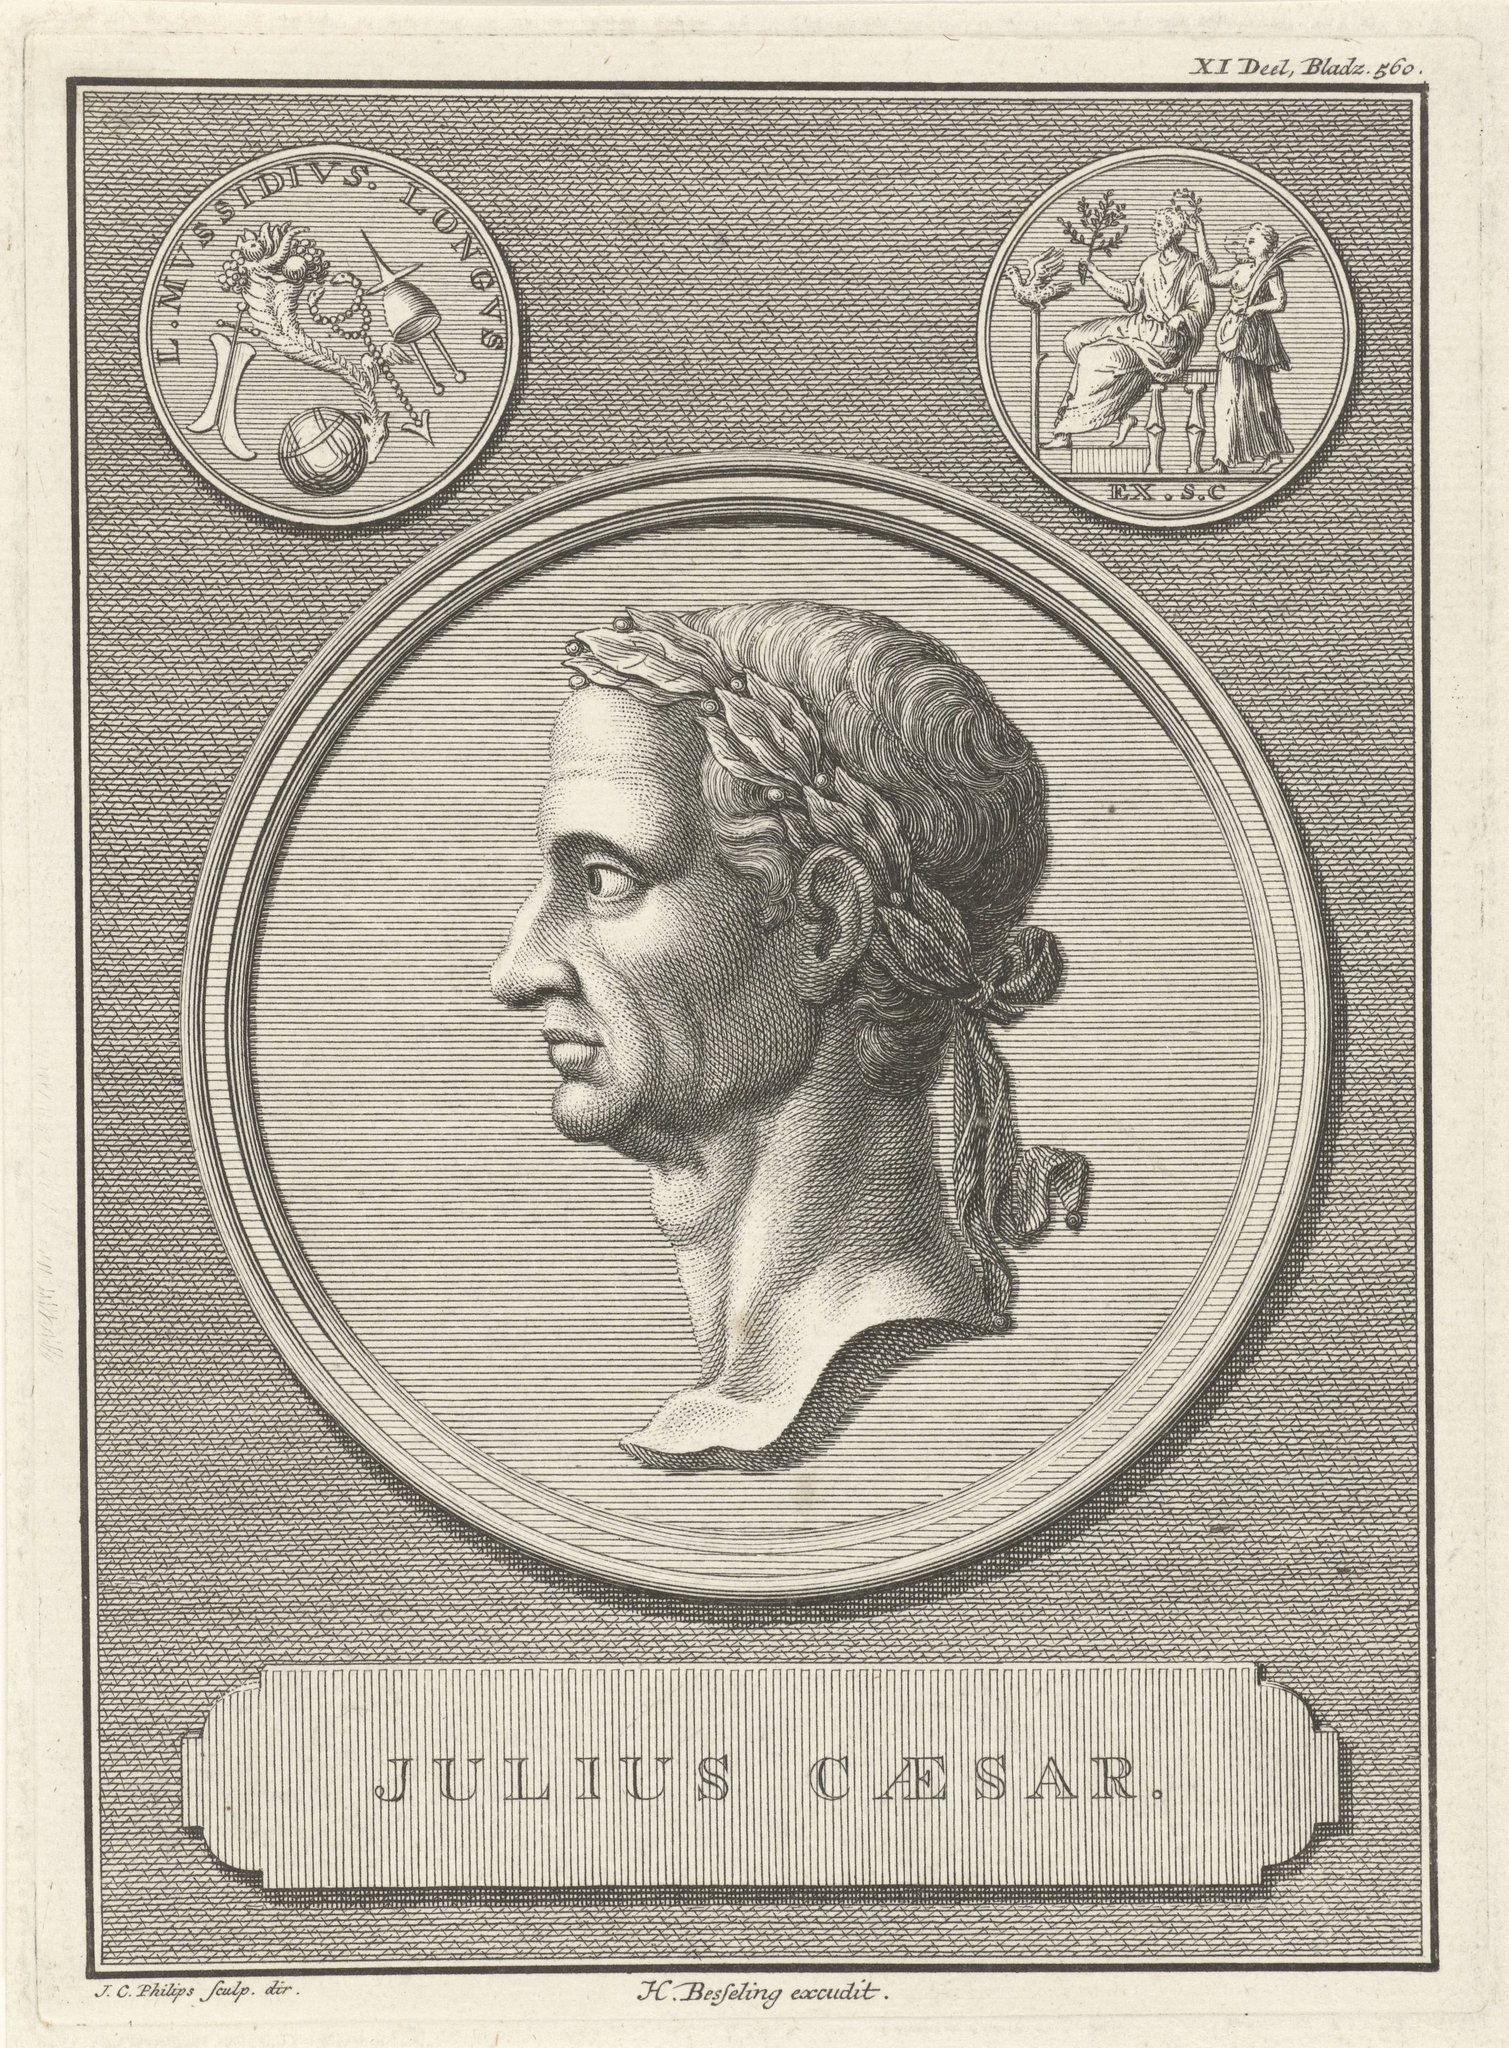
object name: print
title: Portret van Julius Caesar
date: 1745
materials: paper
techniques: engraving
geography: amsterdam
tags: rome, coin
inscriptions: collector's mark: Lugt 2233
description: Prent gebruikt als illustratie in: Westerbaen, Kornelis, Algemeene histori van het begin der wereld af tot den tegenwoordigen tijd toe, deel XI. Utrecht: Herman Besseling, 1745.